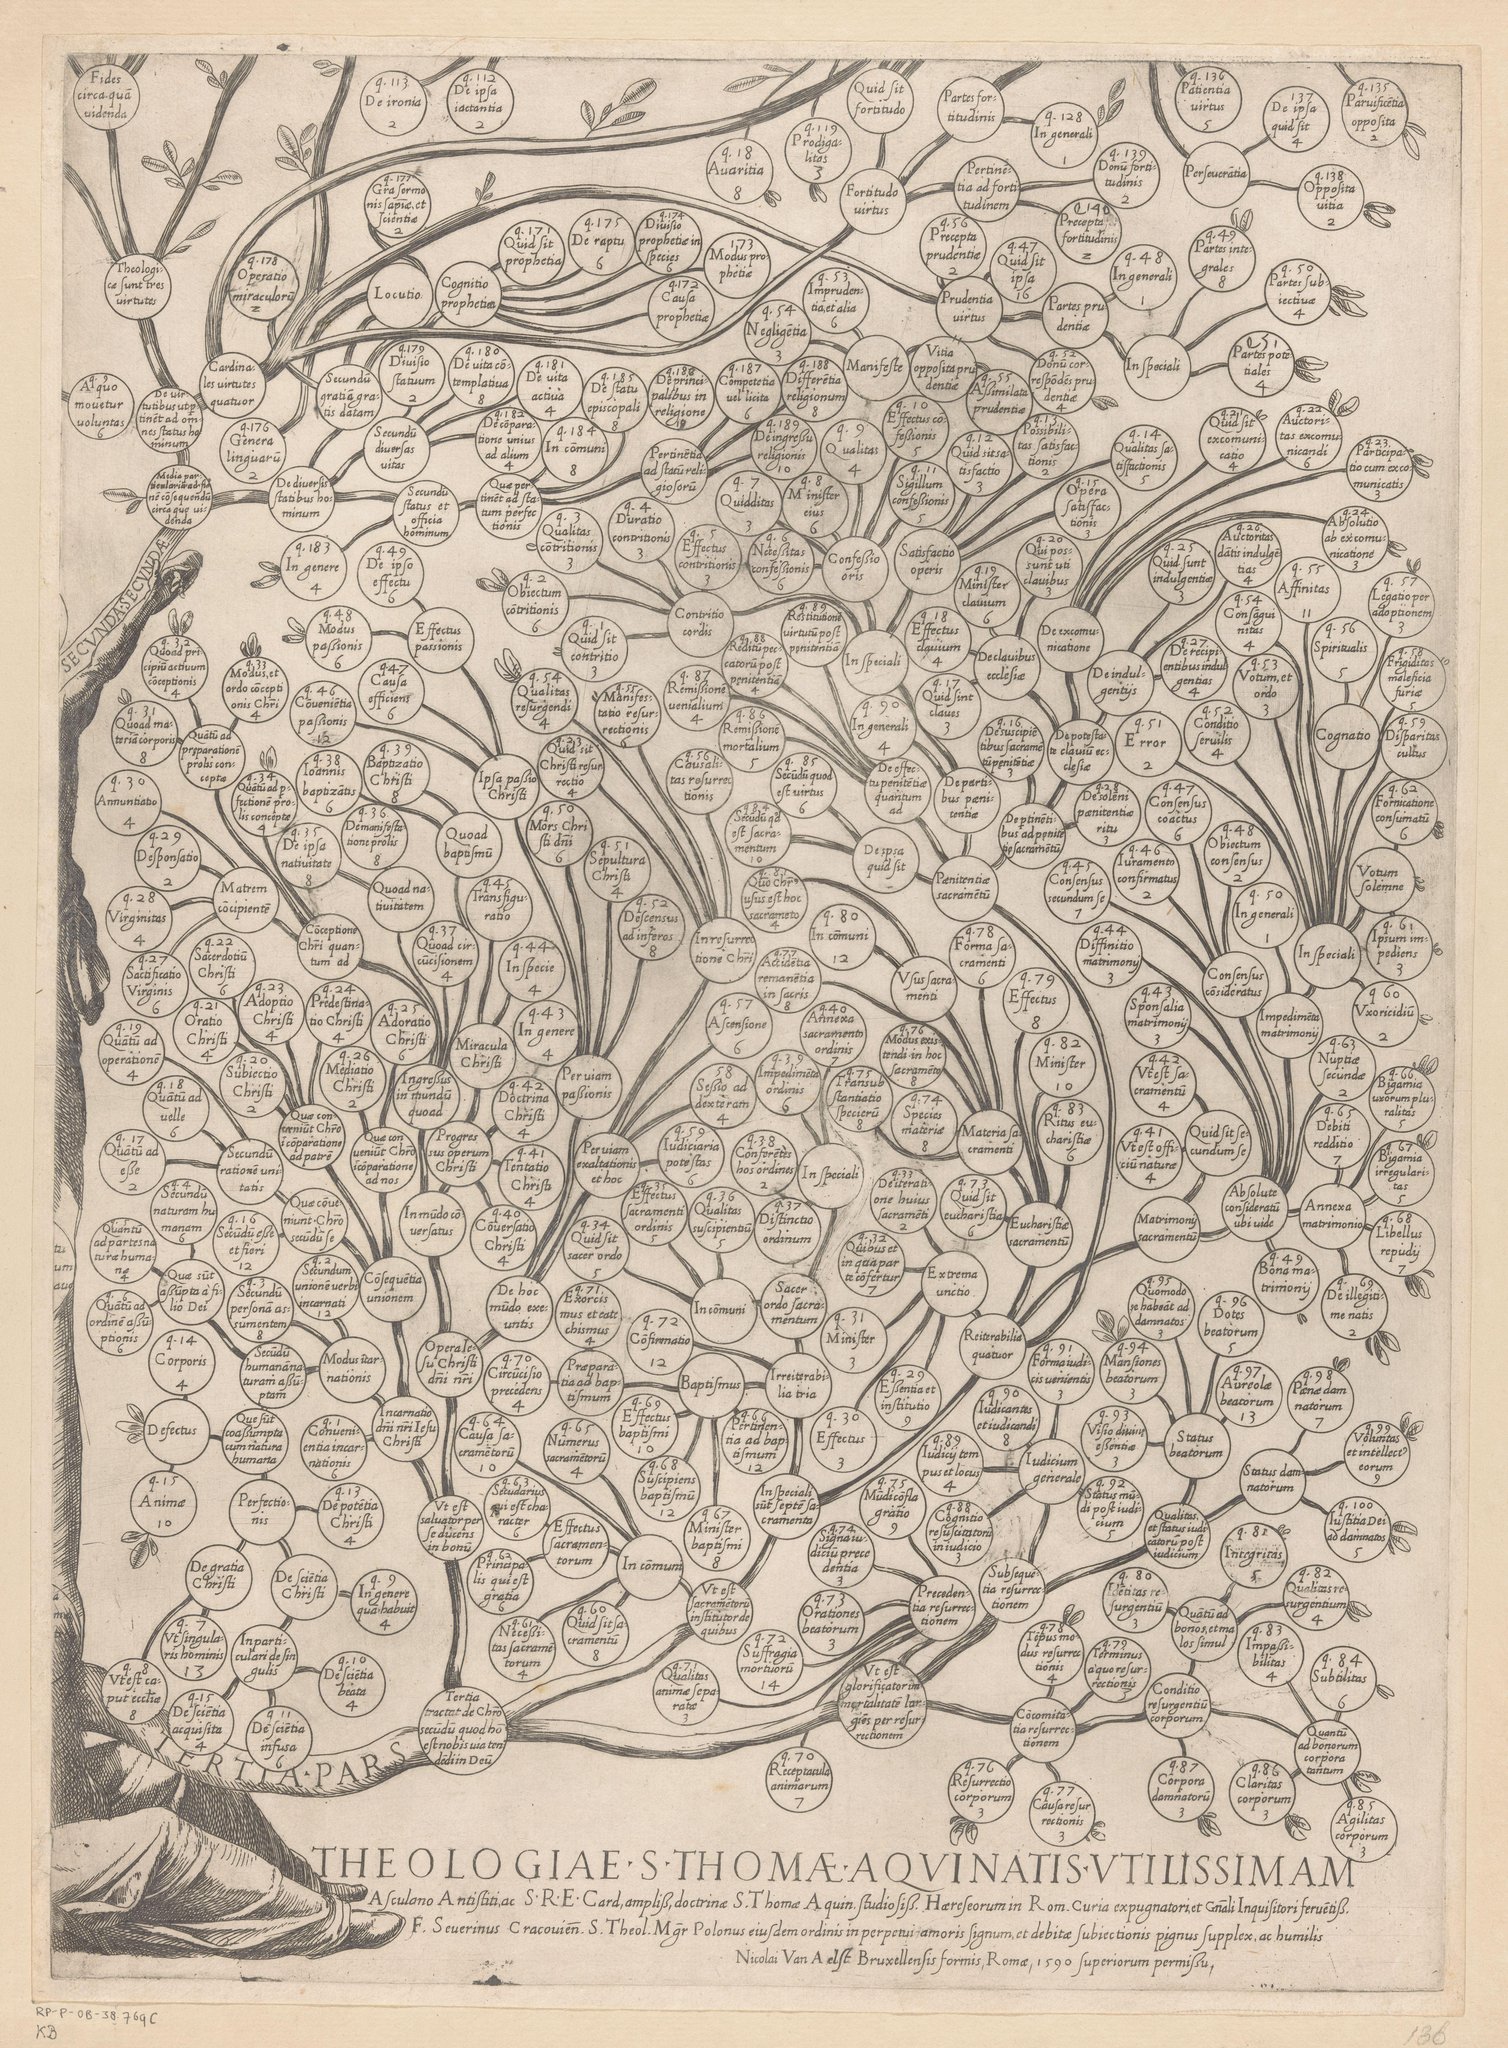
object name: print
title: Boom met Thomas van Aquino (deel rechtsonder)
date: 1590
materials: paper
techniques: etching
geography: vatican city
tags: thomas van aquino, christ crucified on a tree or on a vine, christian doctrine, the dominican theologian, 'angelic doctor' thomas of aquino; possible attributes: book, (chain with) sun, dove, girdle of chastity, lily, model of church, monstrance (or chalice), mitre (under feet), star (on breast)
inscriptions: collector's mark: Lugt 240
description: De filosoof en theoloog Thomas van Aquino ligt onderaan een boom. Op de stam van de boom de gekruisigde Christus. De vertakkingen van de boom representeren de drie delen van Aquino's 'Summa Theologiae'. Bovenaan in het midden God de Vader en de Heilige Geest als duif. Linksboven en rechtsboven een wapenschild.